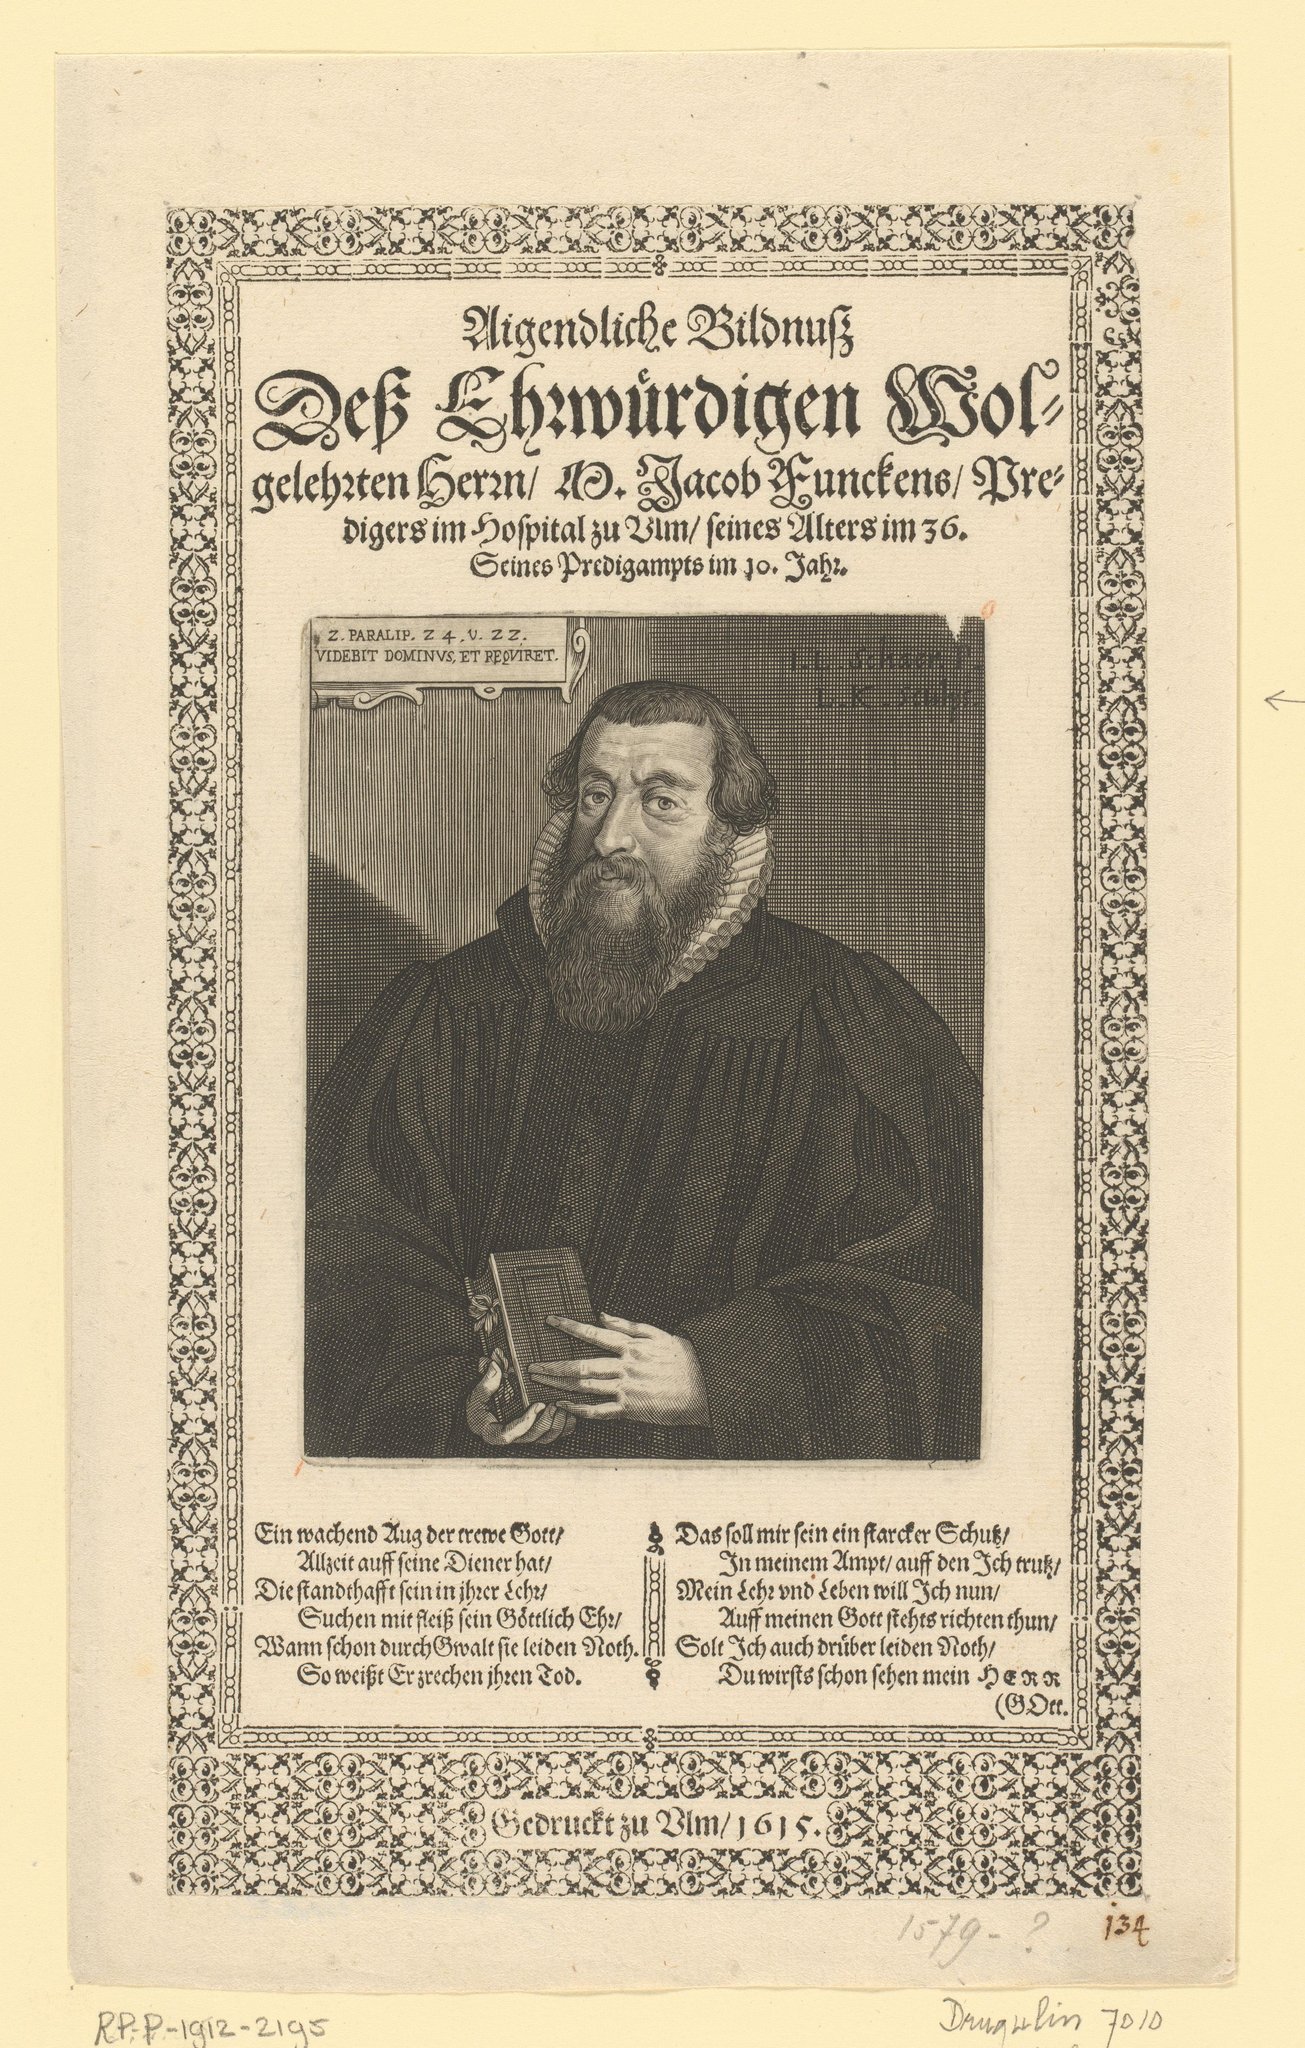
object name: print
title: Eigendliche Bildnuß deß Ehrwürdigen Wolgelehzten Herzn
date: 1615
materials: paper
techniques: engraving, letterpress printing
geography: ulm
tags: historical persons, book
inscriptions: collector's mark: Lugt 2228